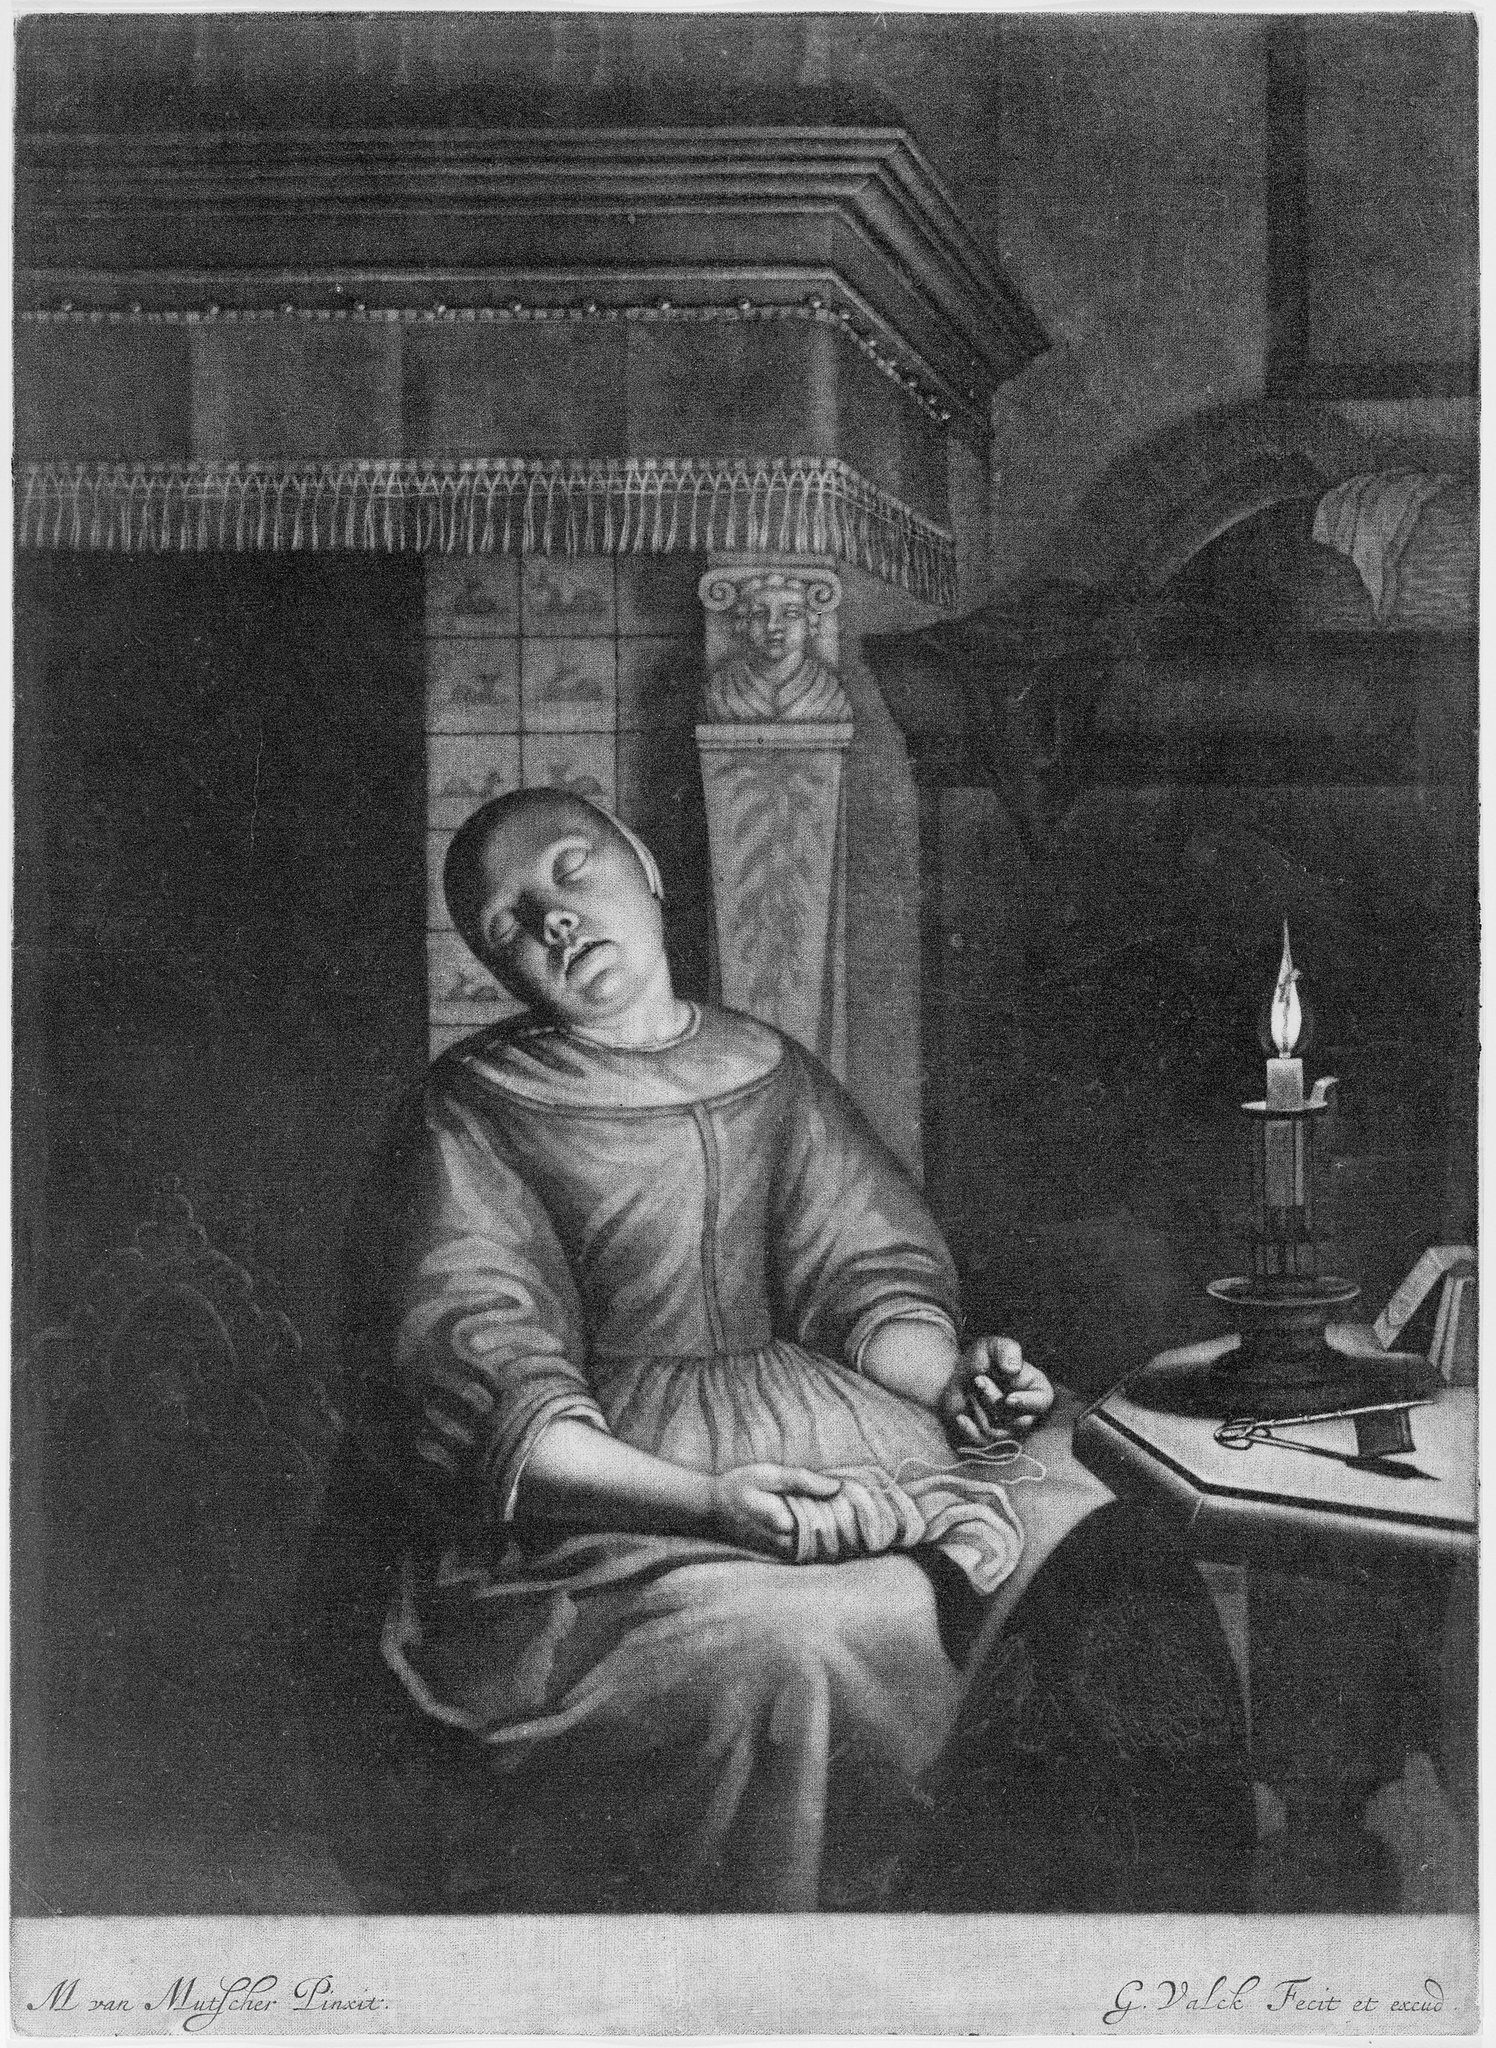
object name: print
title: Sleeping Girl with Needlework in her Lap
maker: gerard valck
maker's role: artist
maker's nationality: dutch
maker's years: 1651-1726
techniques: mezzotint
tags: sleeping,girls,needlework